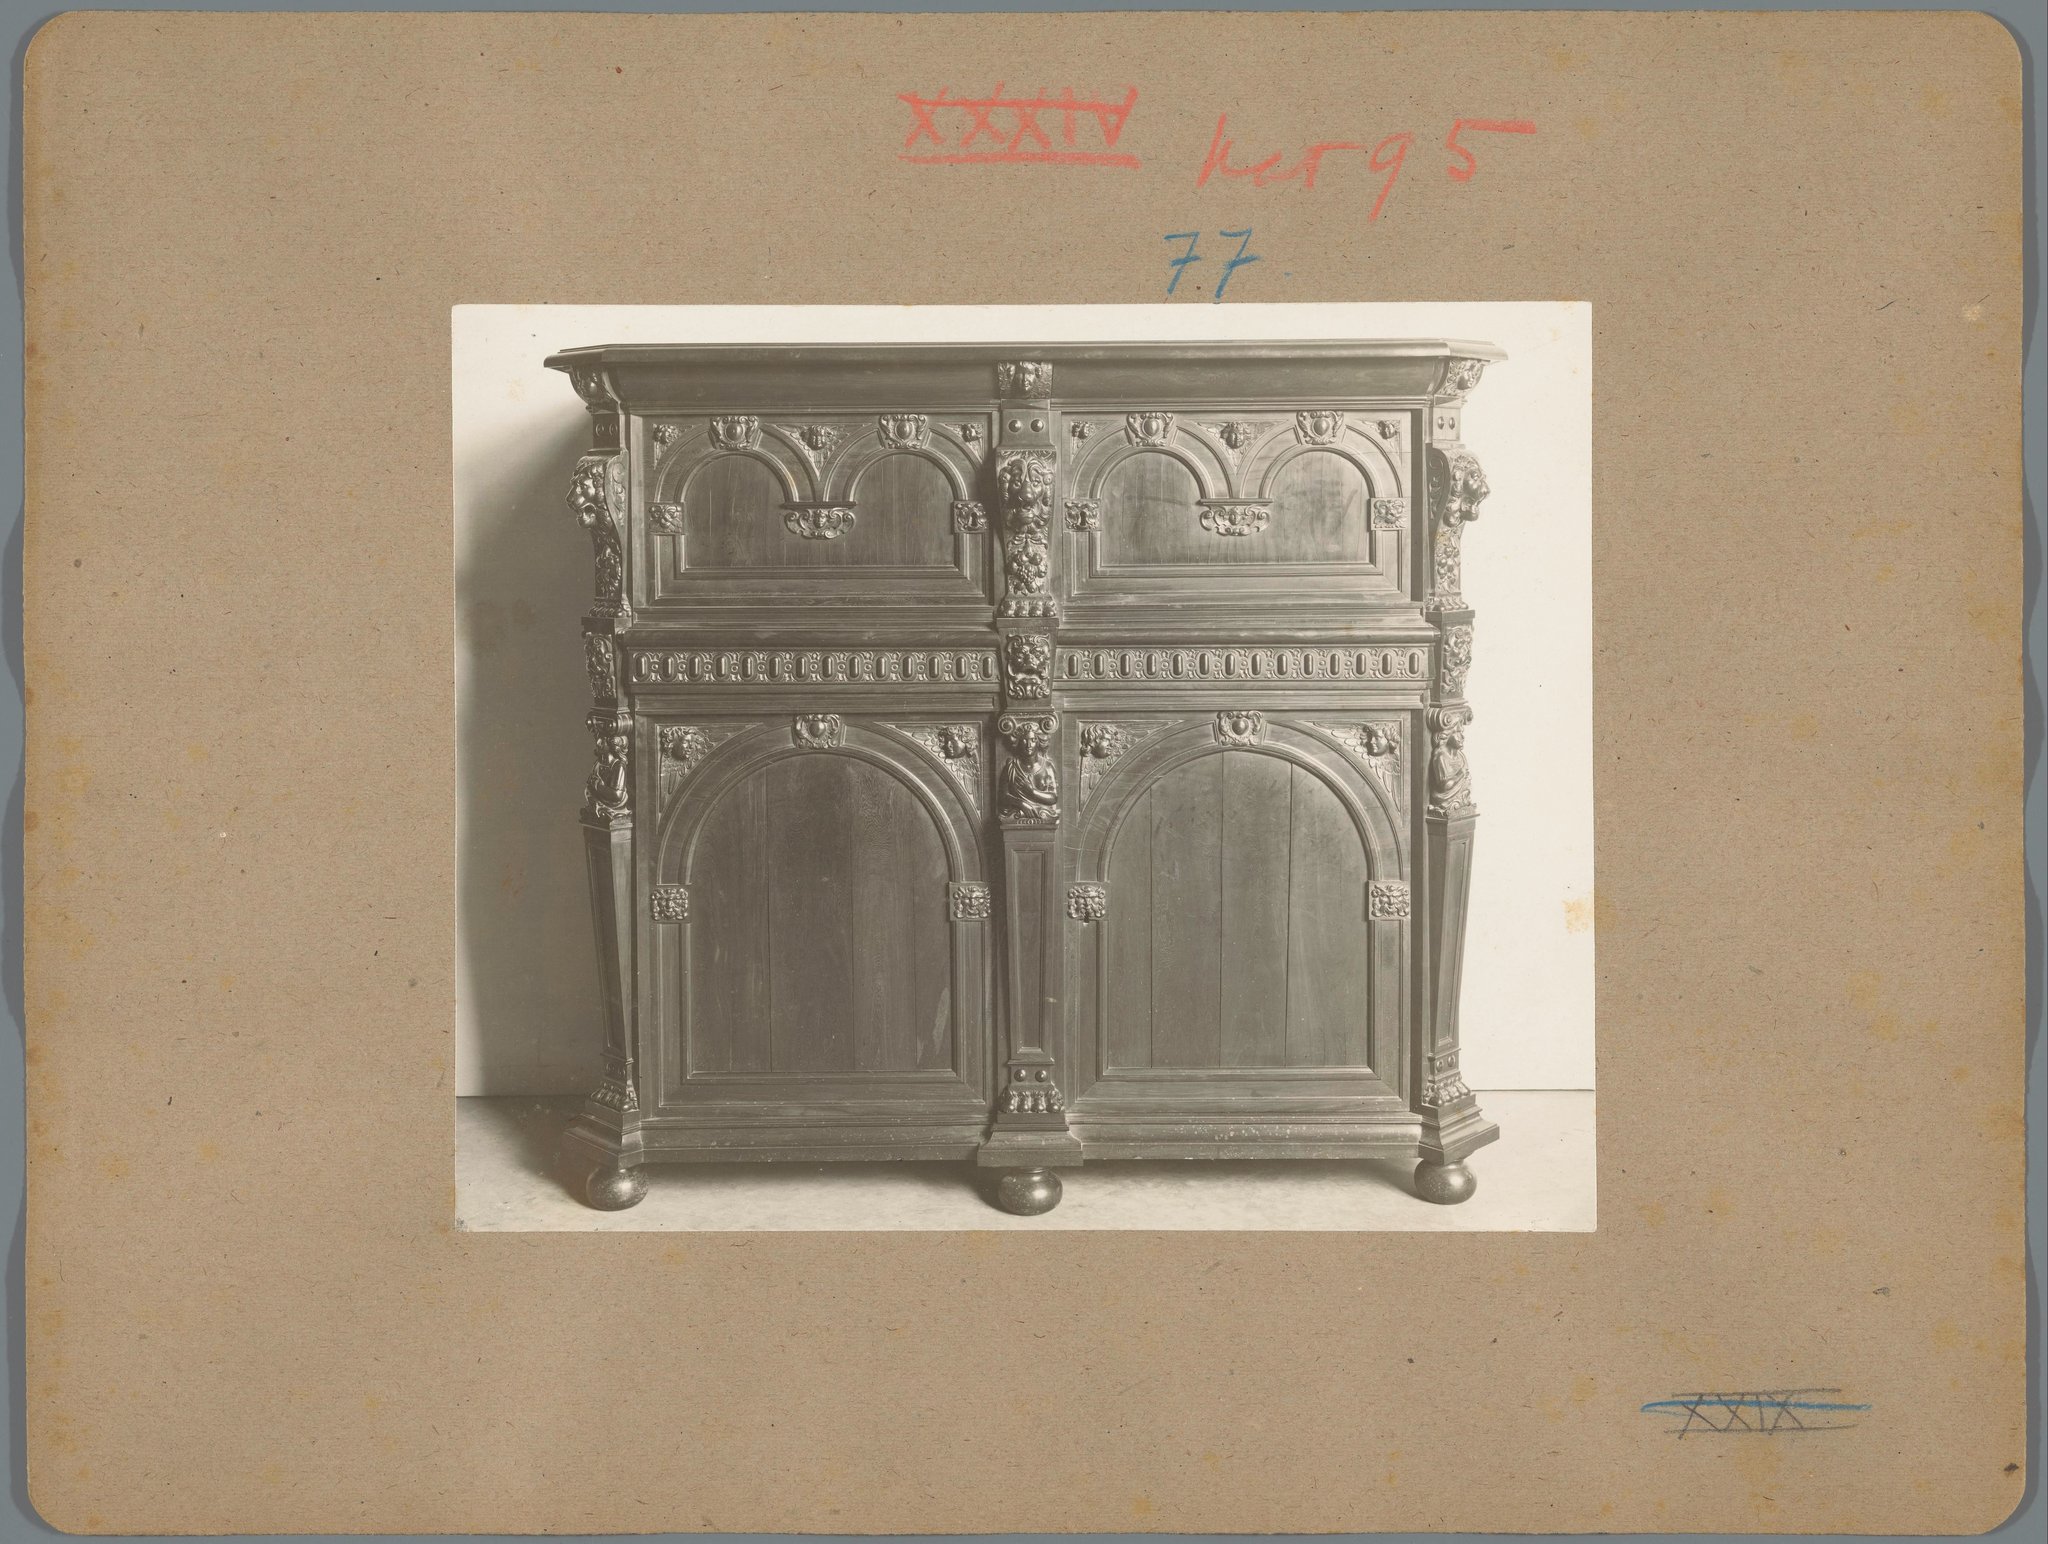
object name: photograph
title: Kast geornamenteerd met leeuwenkoppen en vermoedelijk de drie gratiën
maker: Anonymous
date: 1875-1900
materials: cardboard, photographic support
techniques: gelatin silver print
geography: europe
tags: lion's head ~ ornament, graces (charites), generally three in number; 'gratie' (ripa), cupboard, europe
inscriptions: number: ‘Kat 95’, collector's mark: ‘KUNSTNIJVERHEIDSCHOOL QUELLINUS AMSTERDAM FRANS HALSSTRAAT 14.’, collector's mark: ‘INSTITUUT VOOR KUNST-NIJVERHEIDSONDERWIJS GABRIËL METSUSTRAAT No. 16 AMSTERDAM’, number: ‘77’, number: ‘XXXIV’